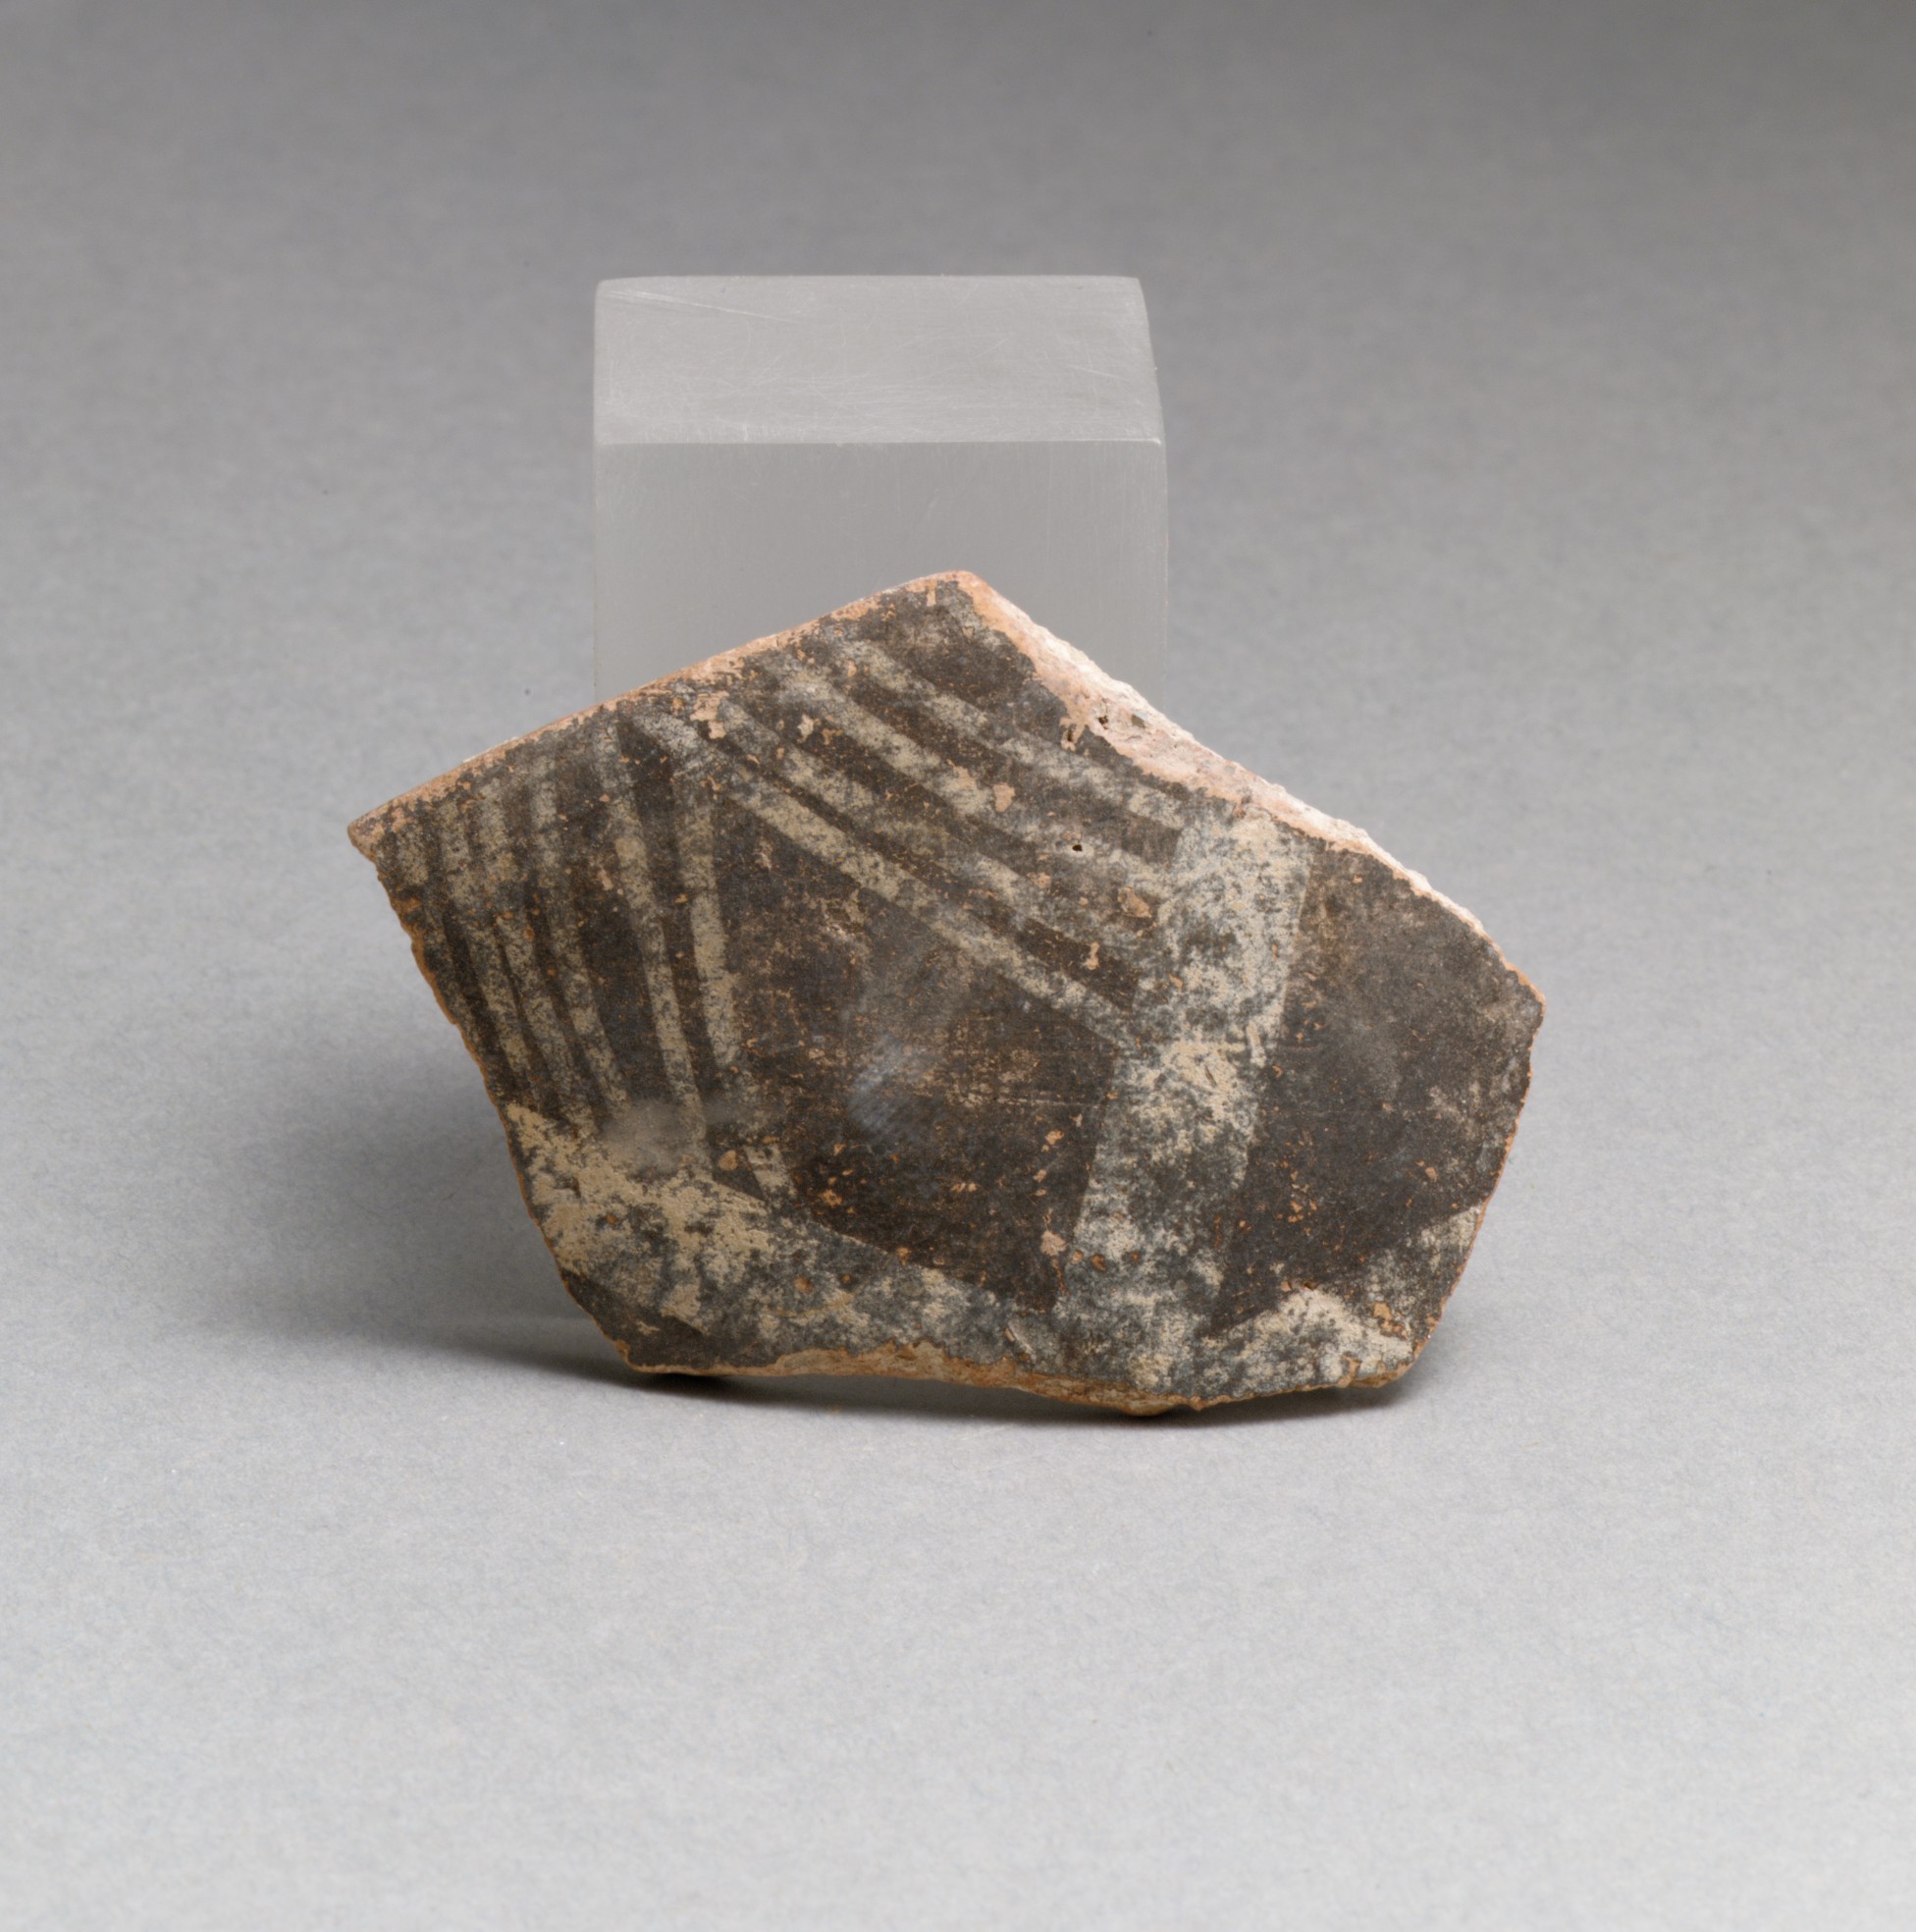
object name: vase fragment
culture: minoan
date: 2600-2000 BCE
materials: terracotta